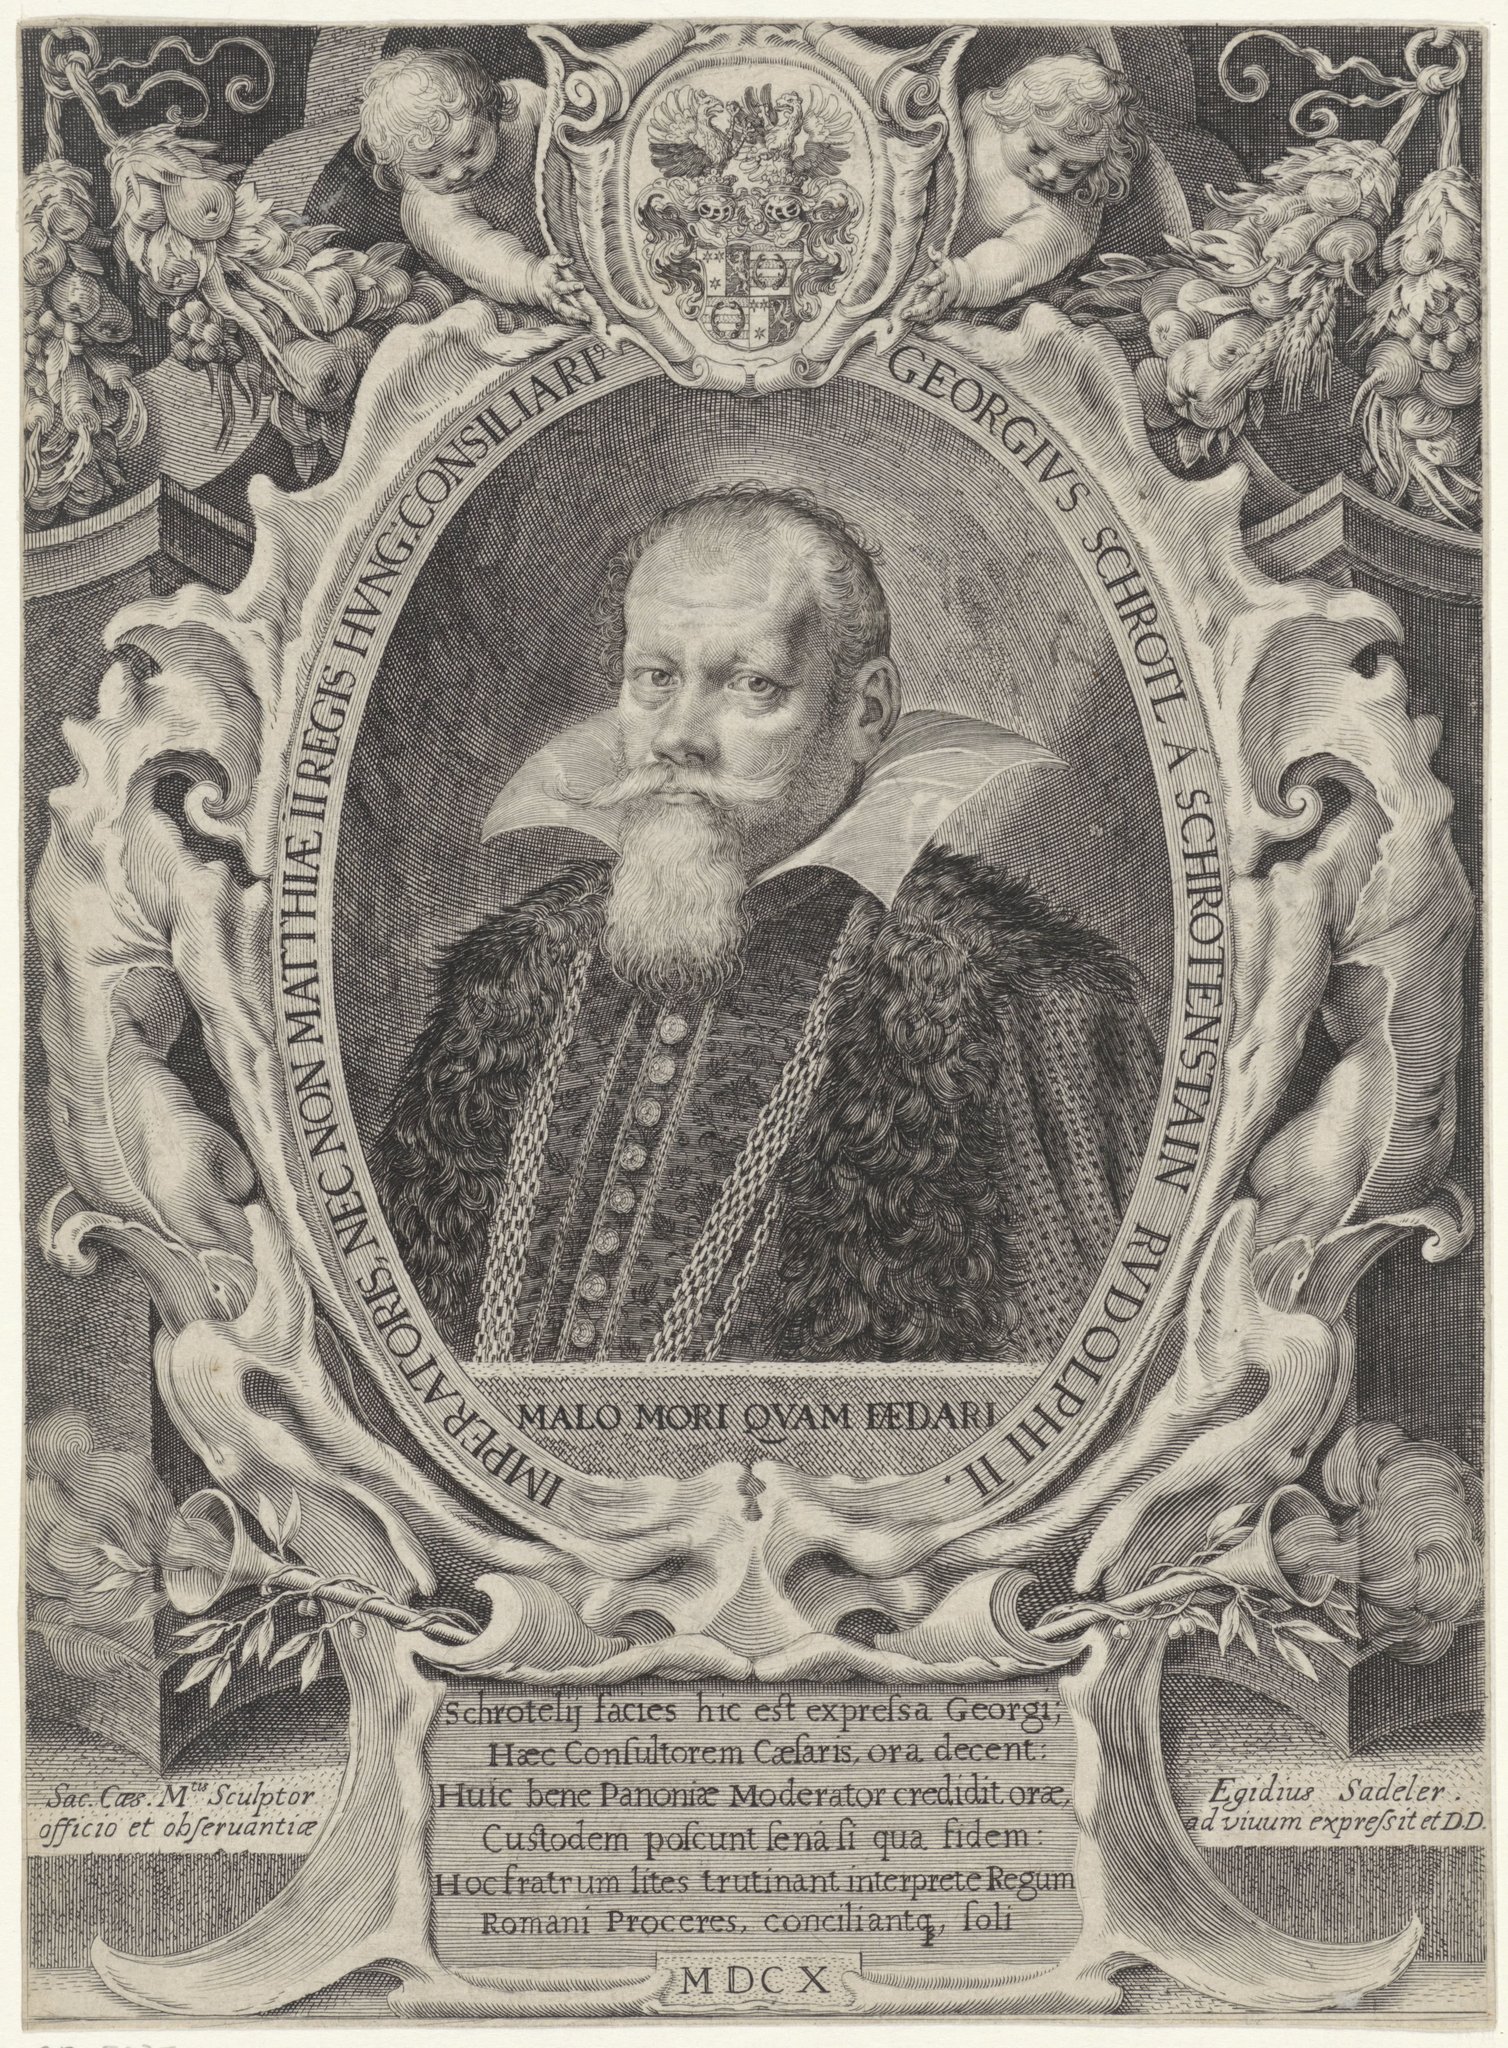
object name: print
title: Portret van Georg Schrötl von Schrotenstein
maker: aegidius sadeler (ii)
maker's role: draughtsman, print maker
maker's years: 1568-1629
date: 1610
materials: paper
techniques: engraving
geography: prague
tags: cupids: 'amores', 'amoretti', 'putti'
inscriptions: collector's mark: Lugt 240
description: Georg Schrotl von Schrotenstain, raadgever van Rudolf II aan het keizerlijk hof in Praag. Bovenaan zijn wapen, vastgehouden door 2 putti. De prent heeft een Latijns onderschrift.